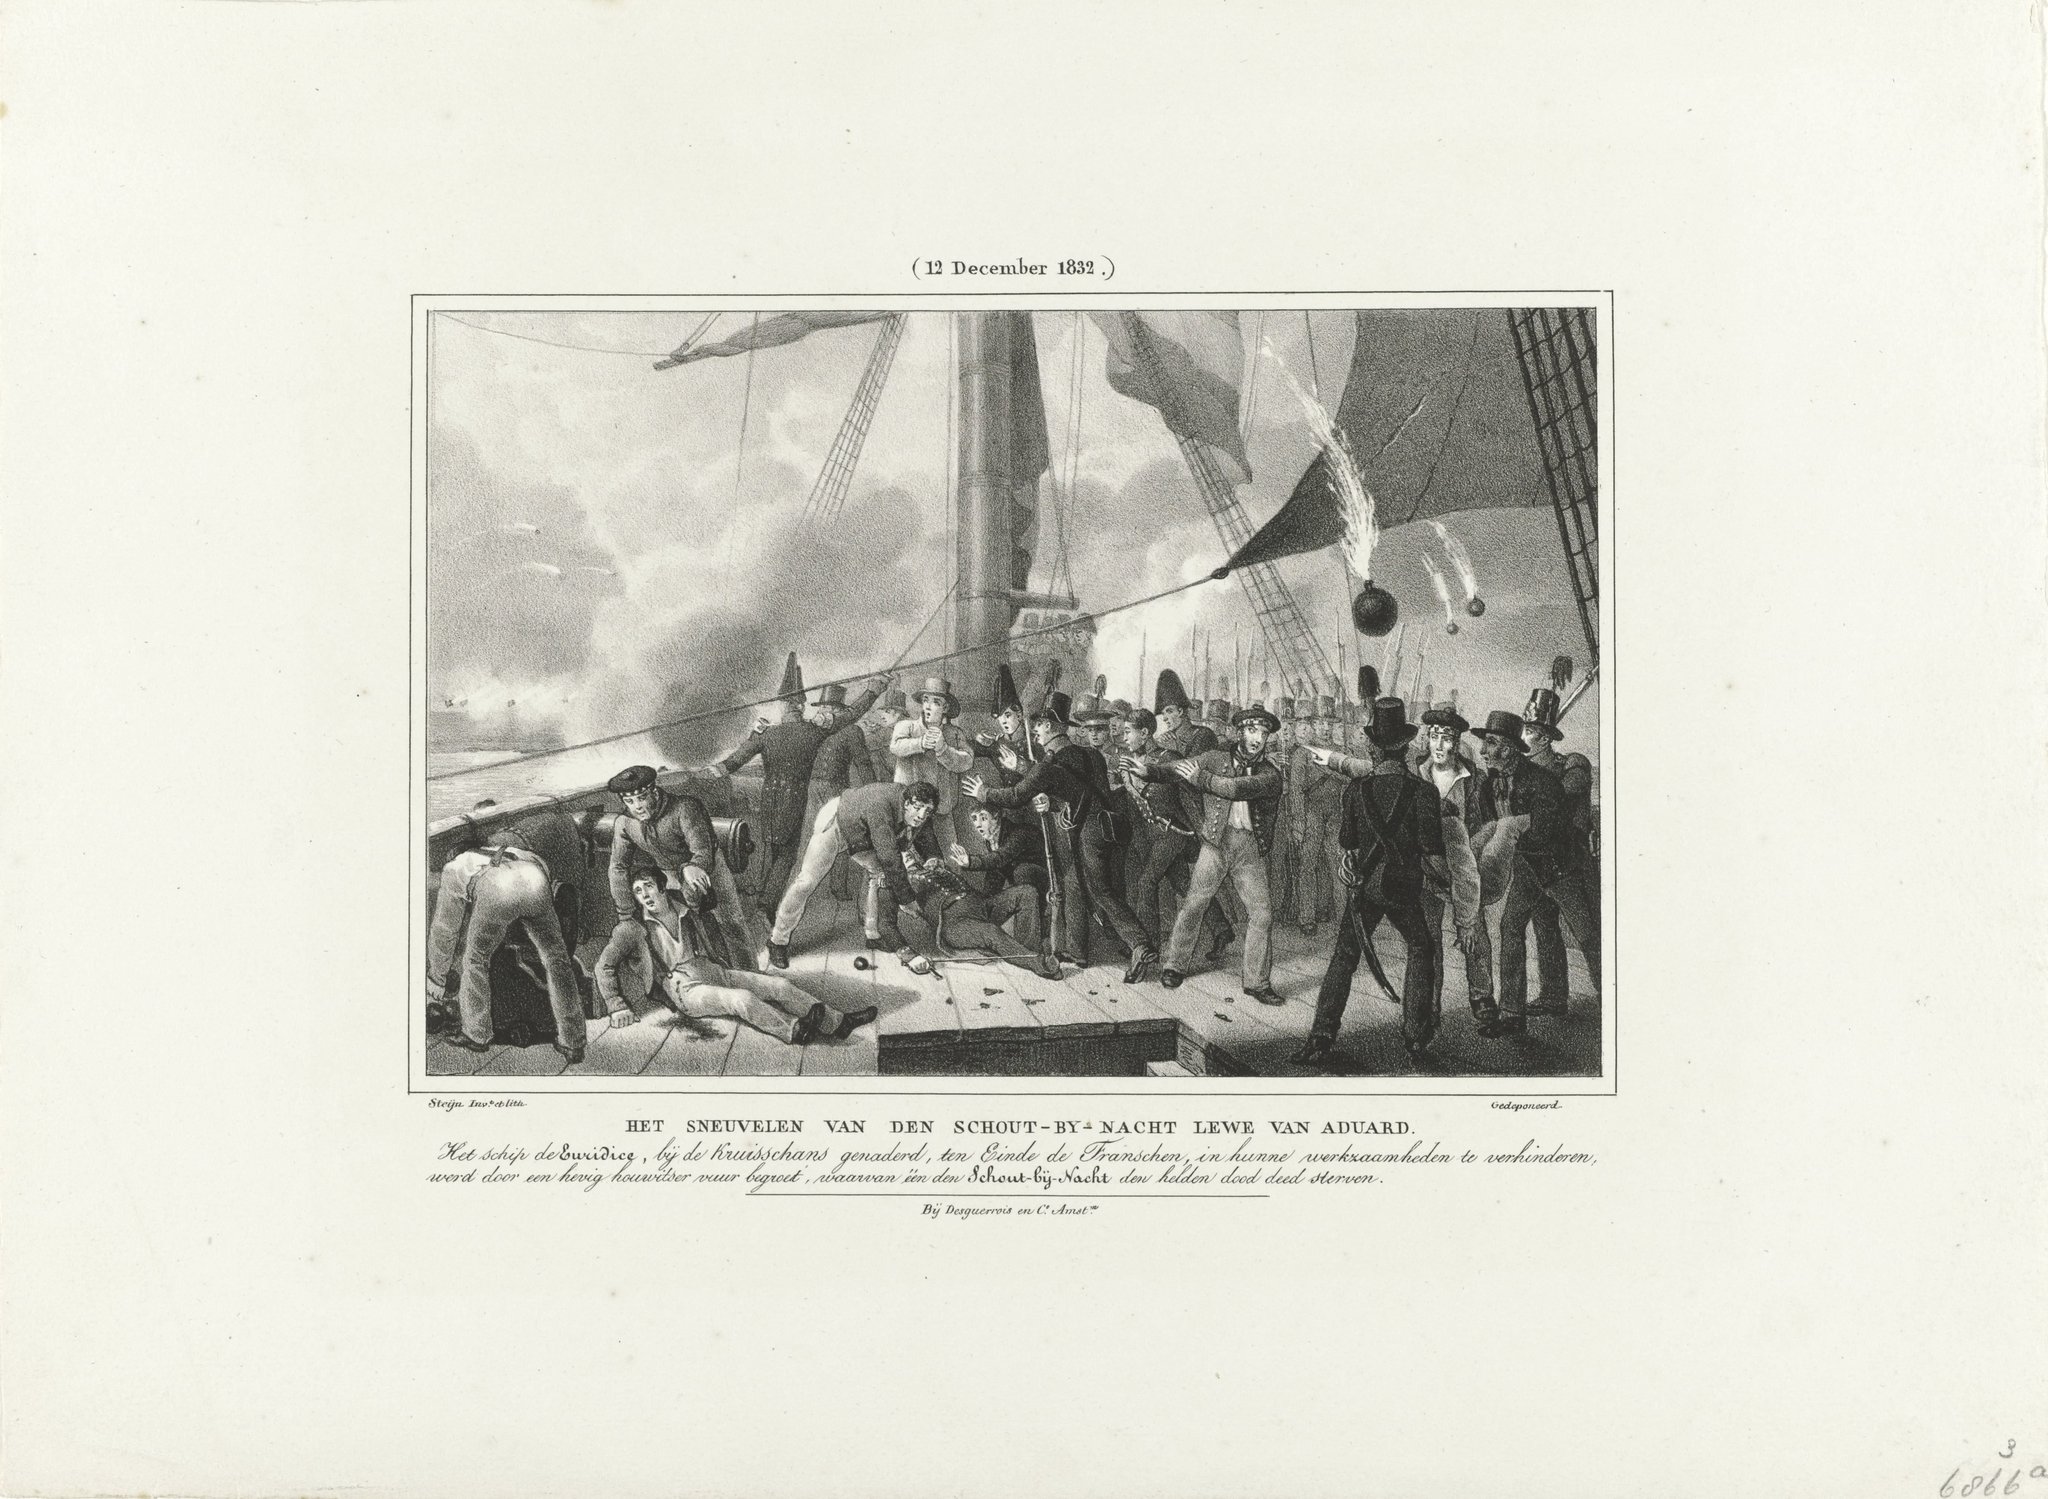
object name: print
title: Het sneuvelen van den schout-by-nacht Lewe van Aduard / (12 December 1832.)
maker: johannes steyn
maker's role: print maker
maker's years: 1805-1840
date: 1832-1833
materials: paper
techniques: lithograph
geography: netherlands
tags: bombardment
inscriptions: : ‘Gedeponeerd’, collector's mark: Lugt 2228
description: De schout-bij-nacht Jan Evert Lewe van Aduard sneuvelt aan boord van het schip de Euridice bij de Kruisschans op de Schelde tijdens een Franse beschieting, 12 december 1832. Onderdeel van een serie van vier platen van de Nederlandse verdediging tijdens het beleg van de Citadel van Antwerpen door het Franse leger, december 1832.